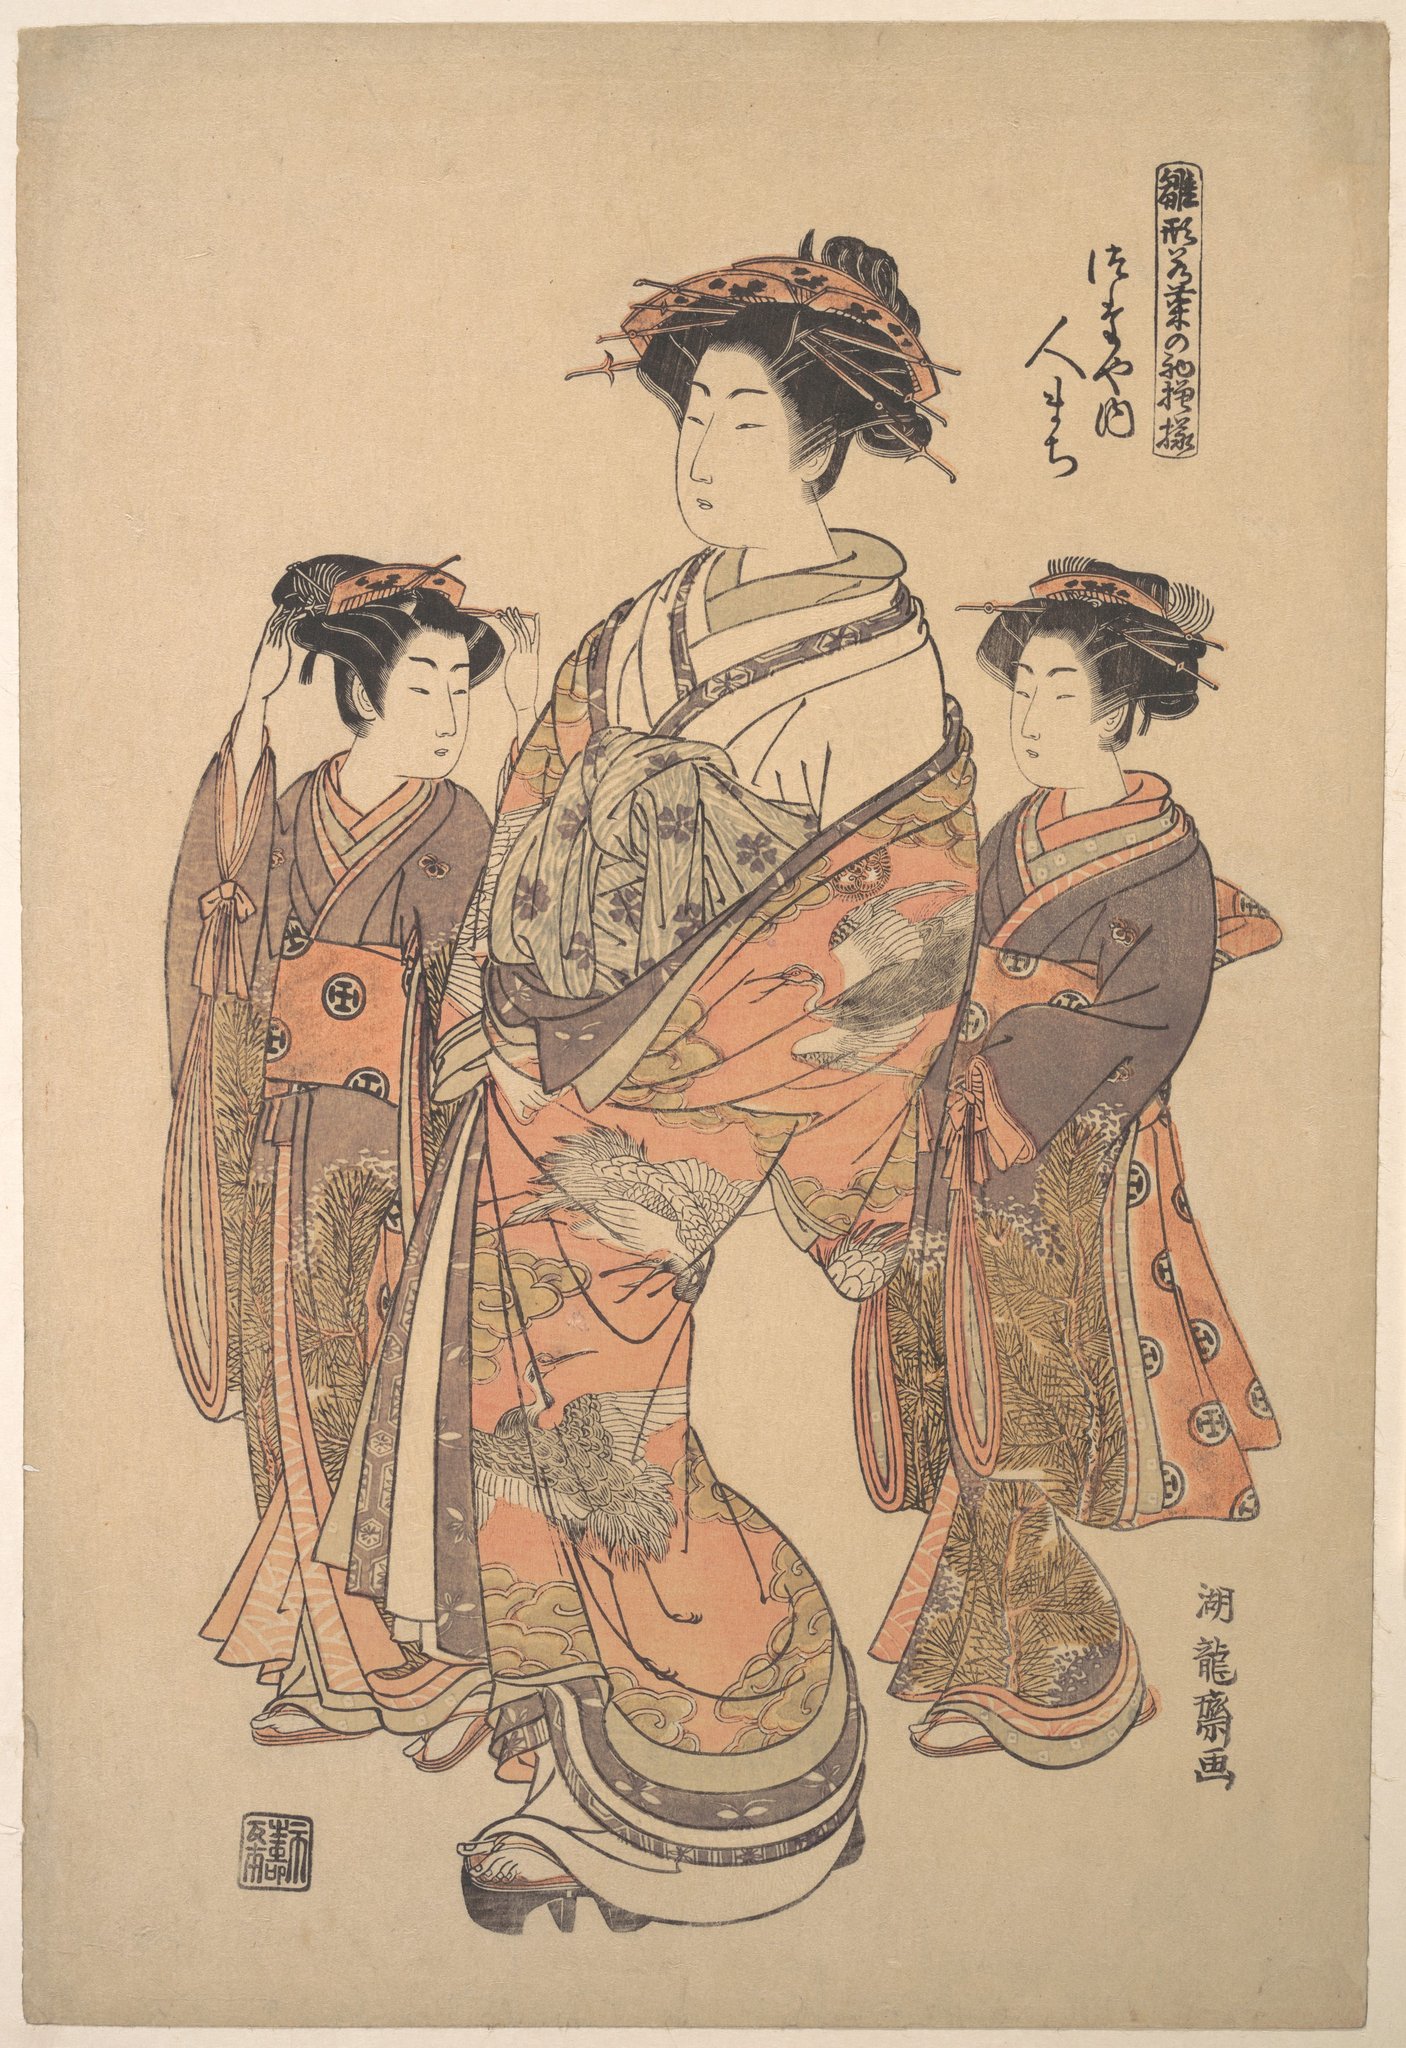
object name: print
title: The Courtesan Hitomachi of the Tsutaya Brothel, from the series “A Pat-tern Book of the Year’s First Designs, Fresh as Spring Herbs” (“Hinagata wakana no hatsu moyō”)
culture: japanese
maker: isoda koryūsai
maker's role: artist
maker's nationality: japanese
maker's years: 1735-1790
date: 1777-1778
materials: ink, paper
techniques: woodblock print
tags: women